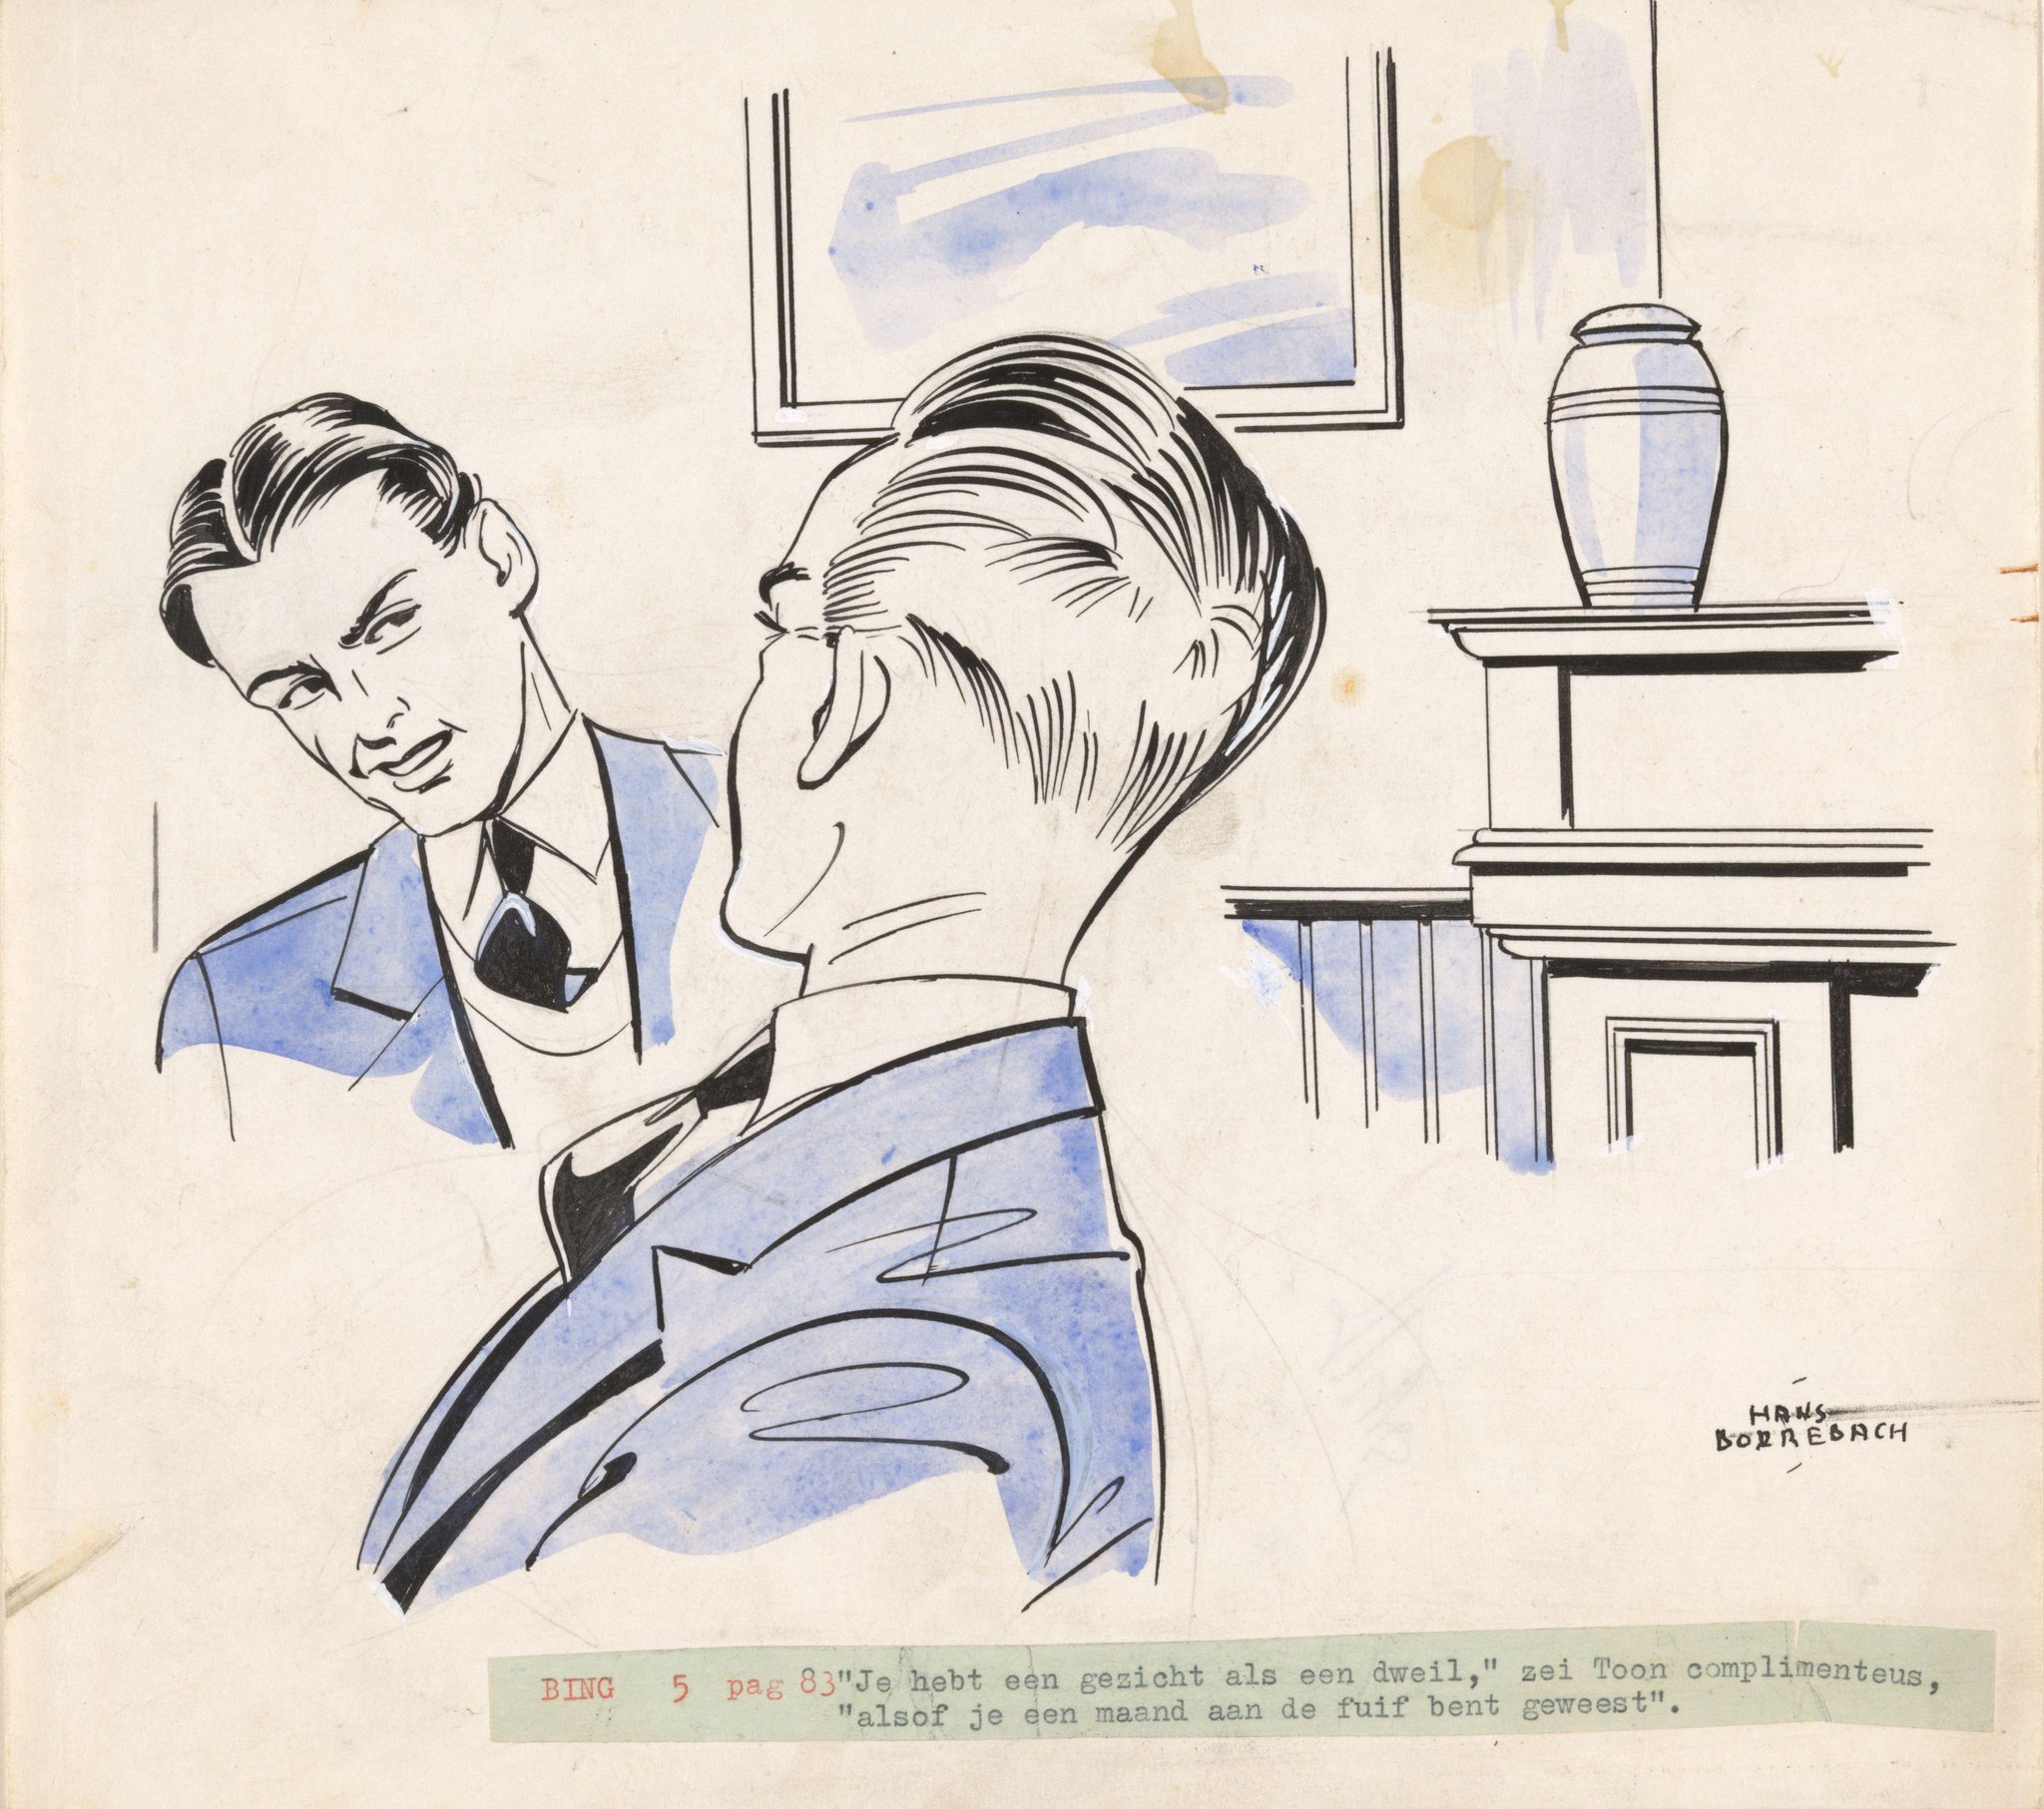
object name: boekillustratie ontwerp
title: Toon bekijkt het gezicht van Piet Bing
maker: hans borrebach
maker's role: draughtsman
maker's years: 1903-1991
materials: paint, ink, paper, pencil, watercolor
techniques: brush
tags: face, looking sideways, living-room, parlour, sitting-room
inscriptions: :, number:, collector's mark: Lugt 2228a, annotation: ‘BING 5 pag 83 "Je hebt een gezicht als een dweil," zei Toon complimenteus,/ "alsof je een maand aan de fuif bent geweest".’, signature: ‘HANS./ BORREBACH’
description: De twee mannen bevinden zich in een woonkamer bij een schoorsteenmantel. Toon bekijkt het gezicht van Piet Bing aandachtig en houdt zijn eigen hoofd daarbij iets opzij.